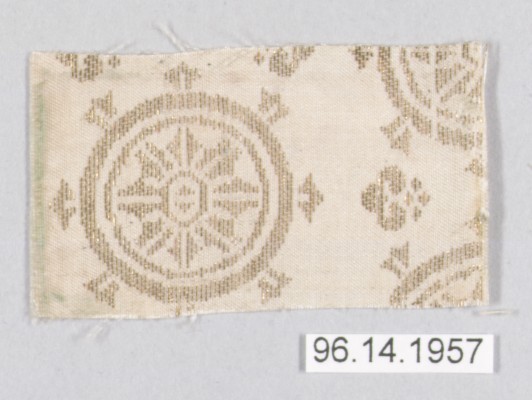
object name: piece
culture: japanese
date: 1701-1900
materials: silk